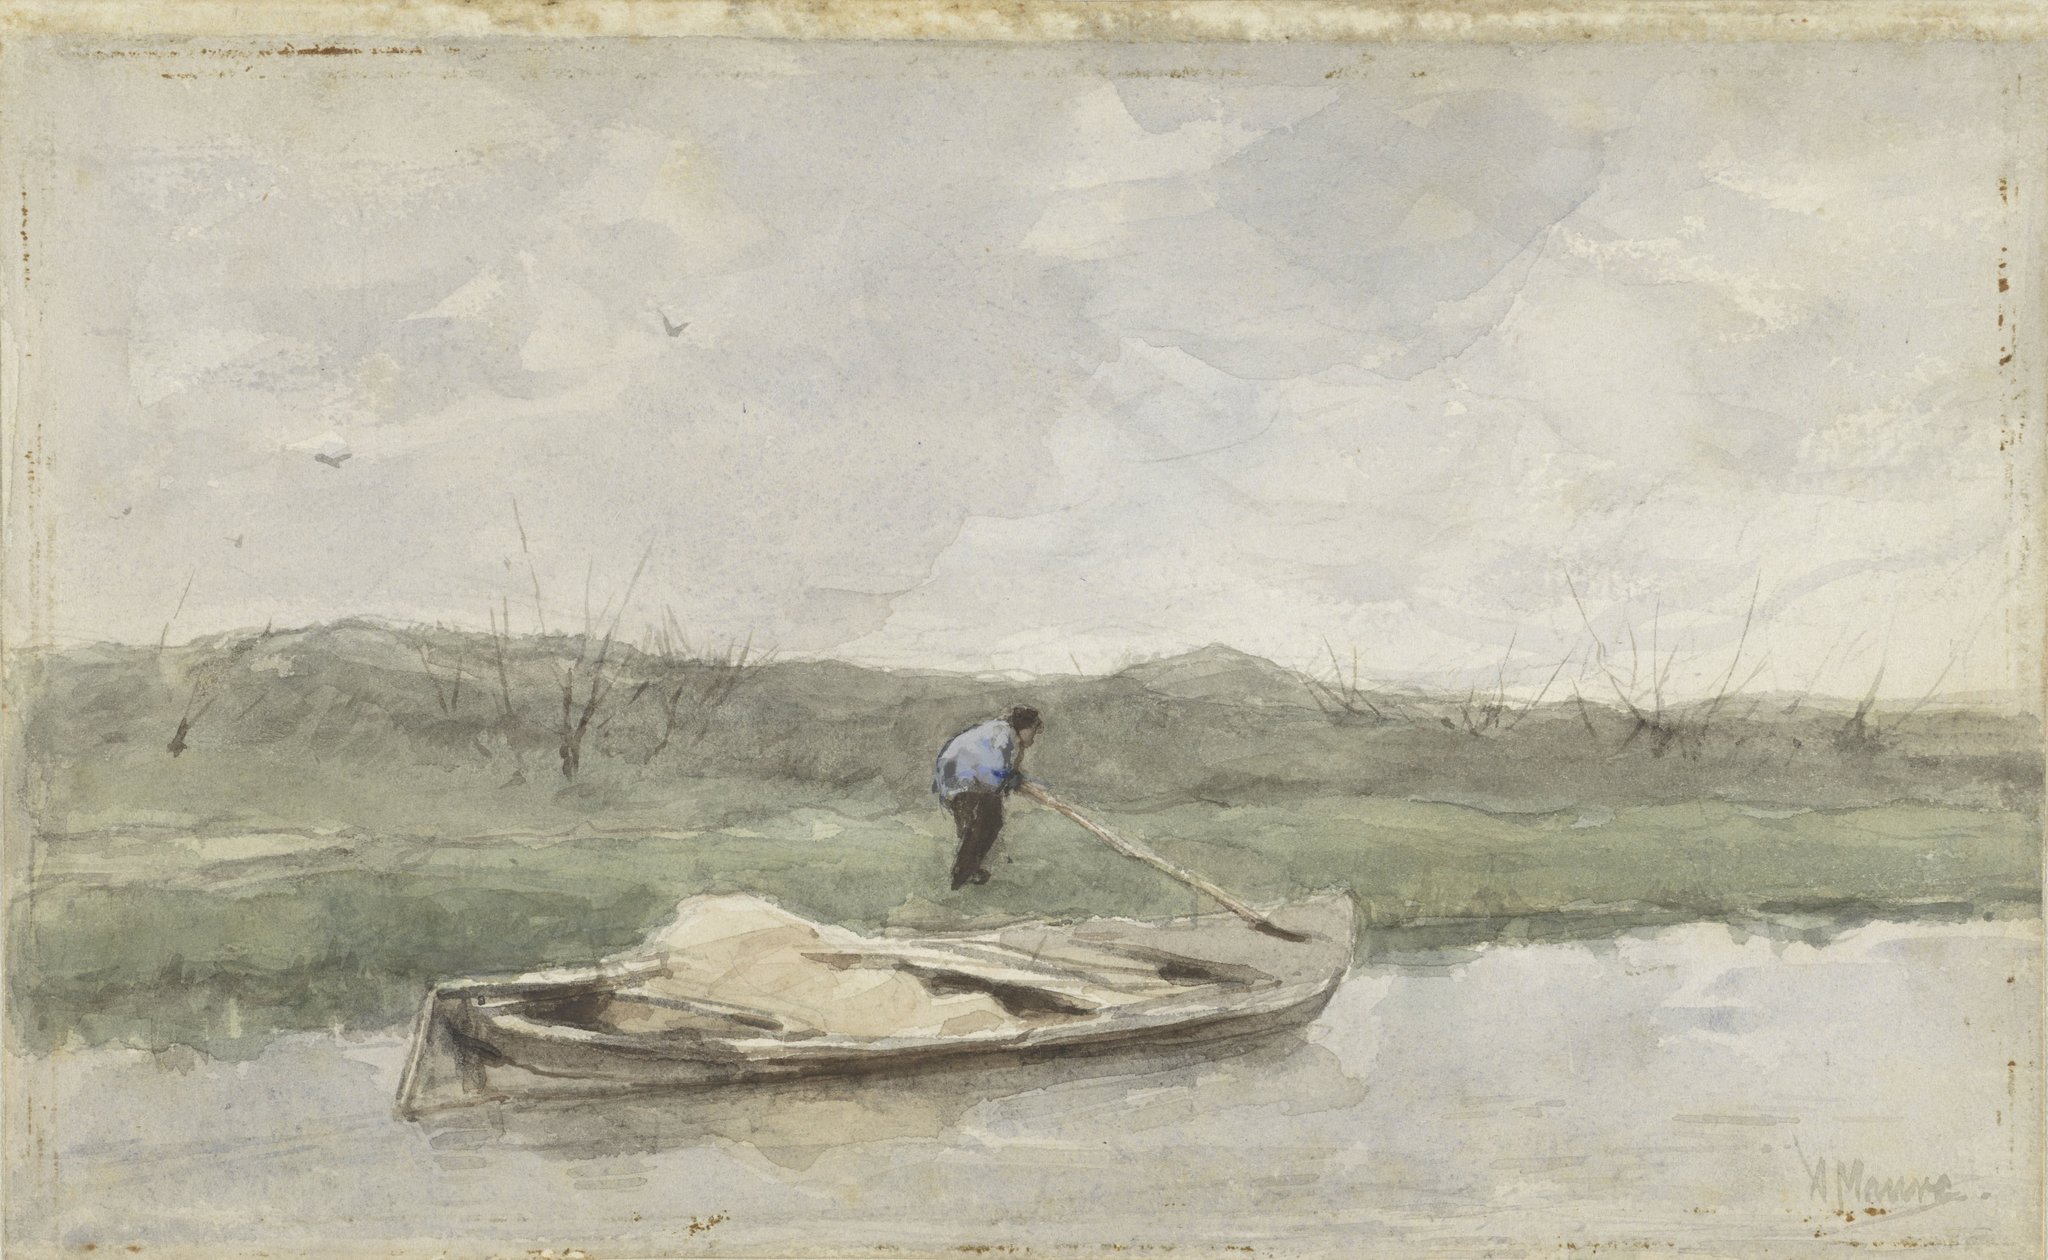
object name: watercolor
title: Zandschuit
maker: anton mauve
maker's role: draughtsman, painter, print maker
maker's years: 1838-1888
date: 1848-1888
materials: paper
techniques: brush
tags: tow-boat, towing-barge (+ propulsion of vehicle, ship, etc. by human power)